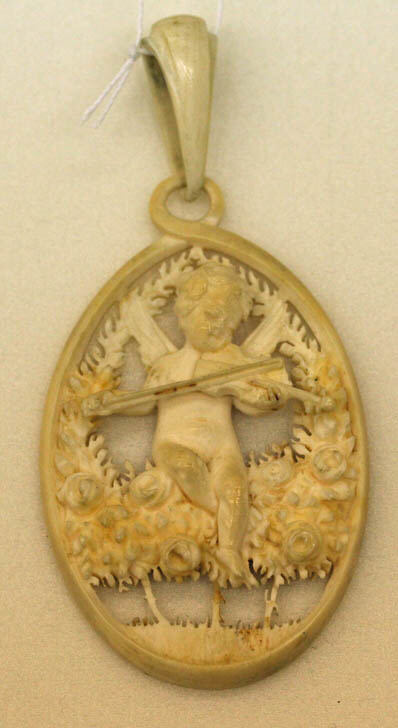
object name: pendant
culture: european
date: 1850-1875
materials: ivory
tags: violins,putti